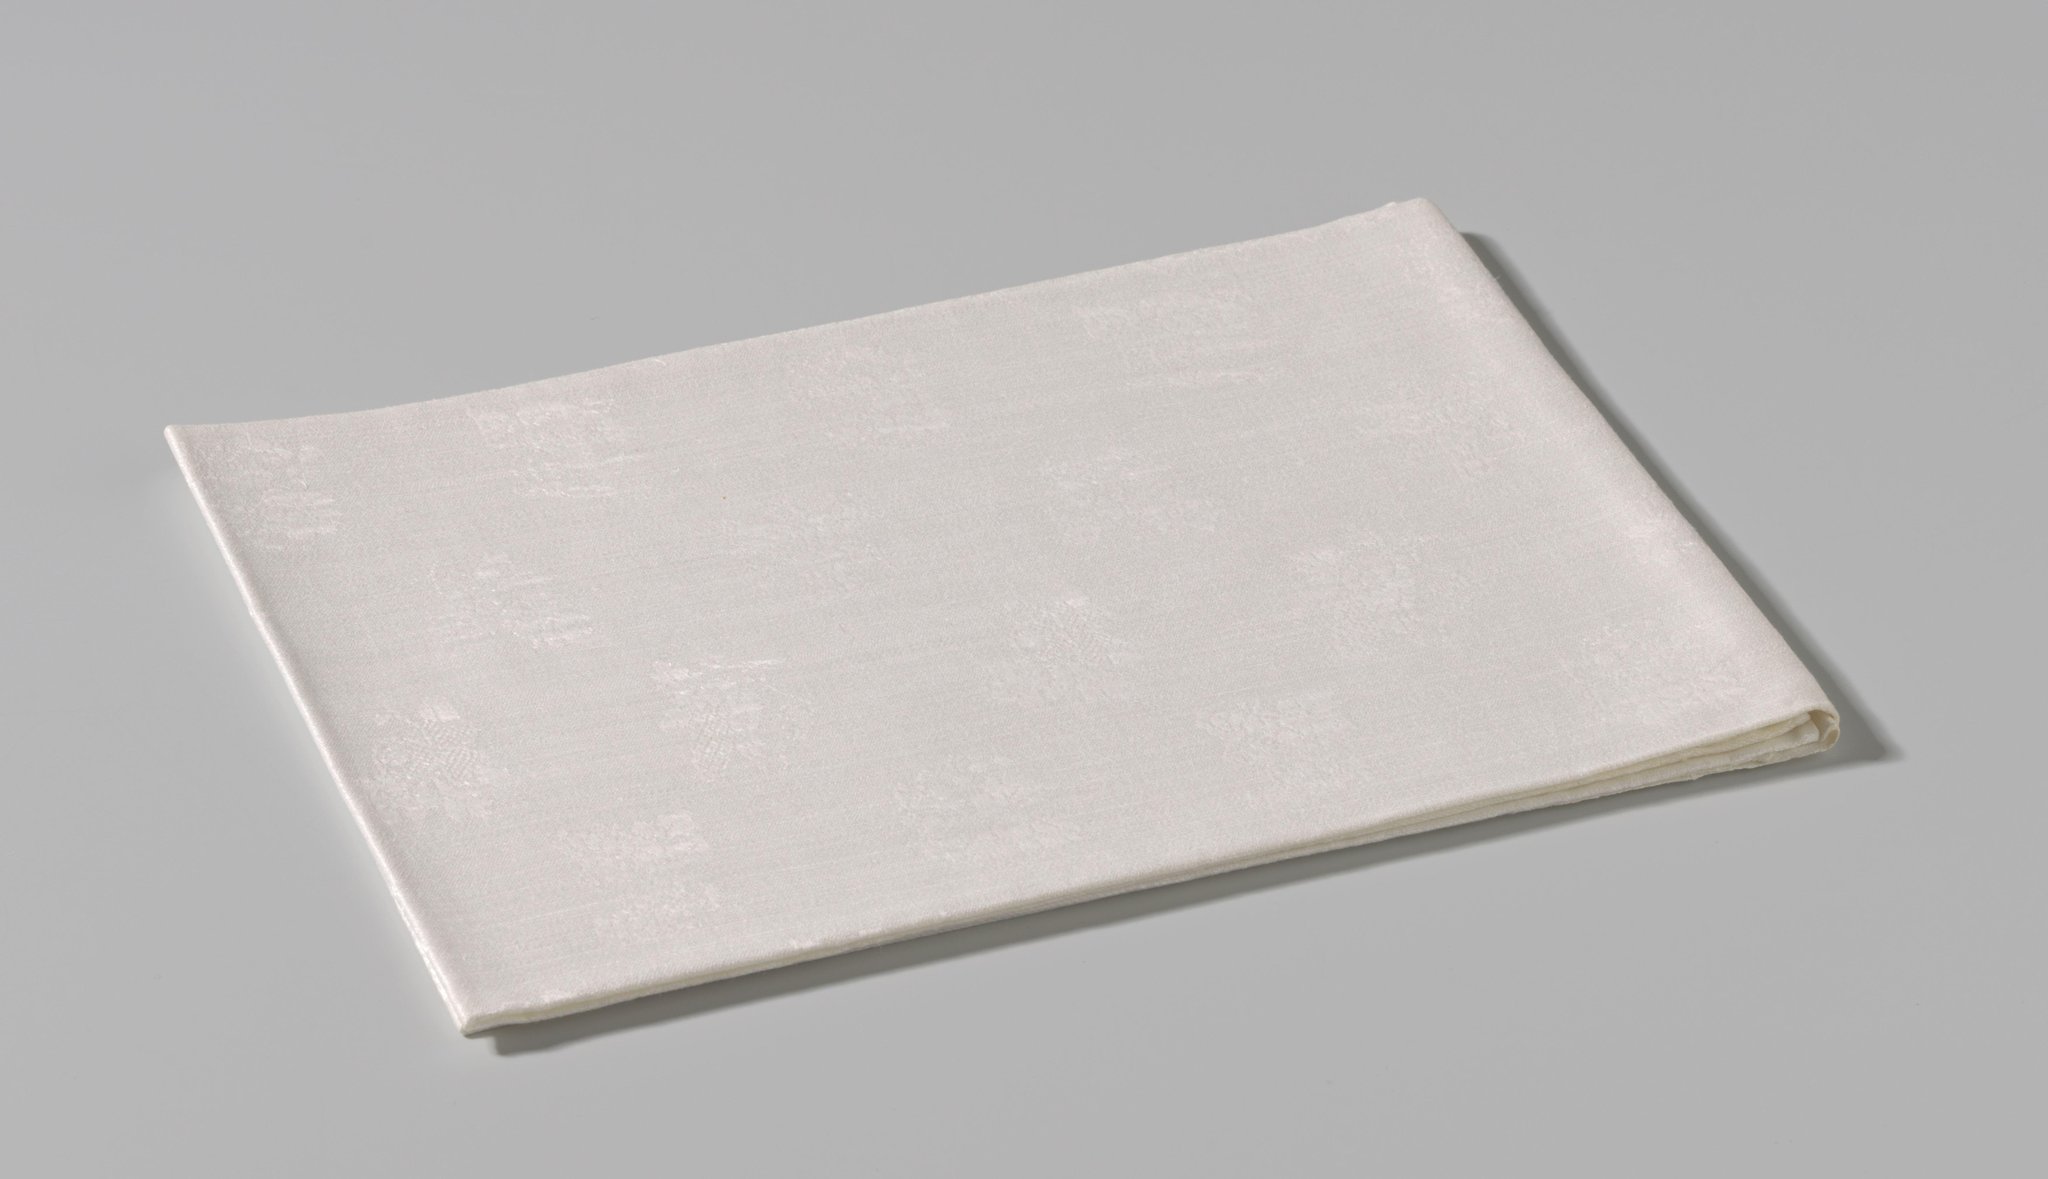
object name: napkin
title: Servet van linnendamast met een bloempatroon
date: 1800-1900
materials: linen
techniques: damask, weave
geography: netherlands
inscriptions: number: ‘24’, mark: ‘MC’